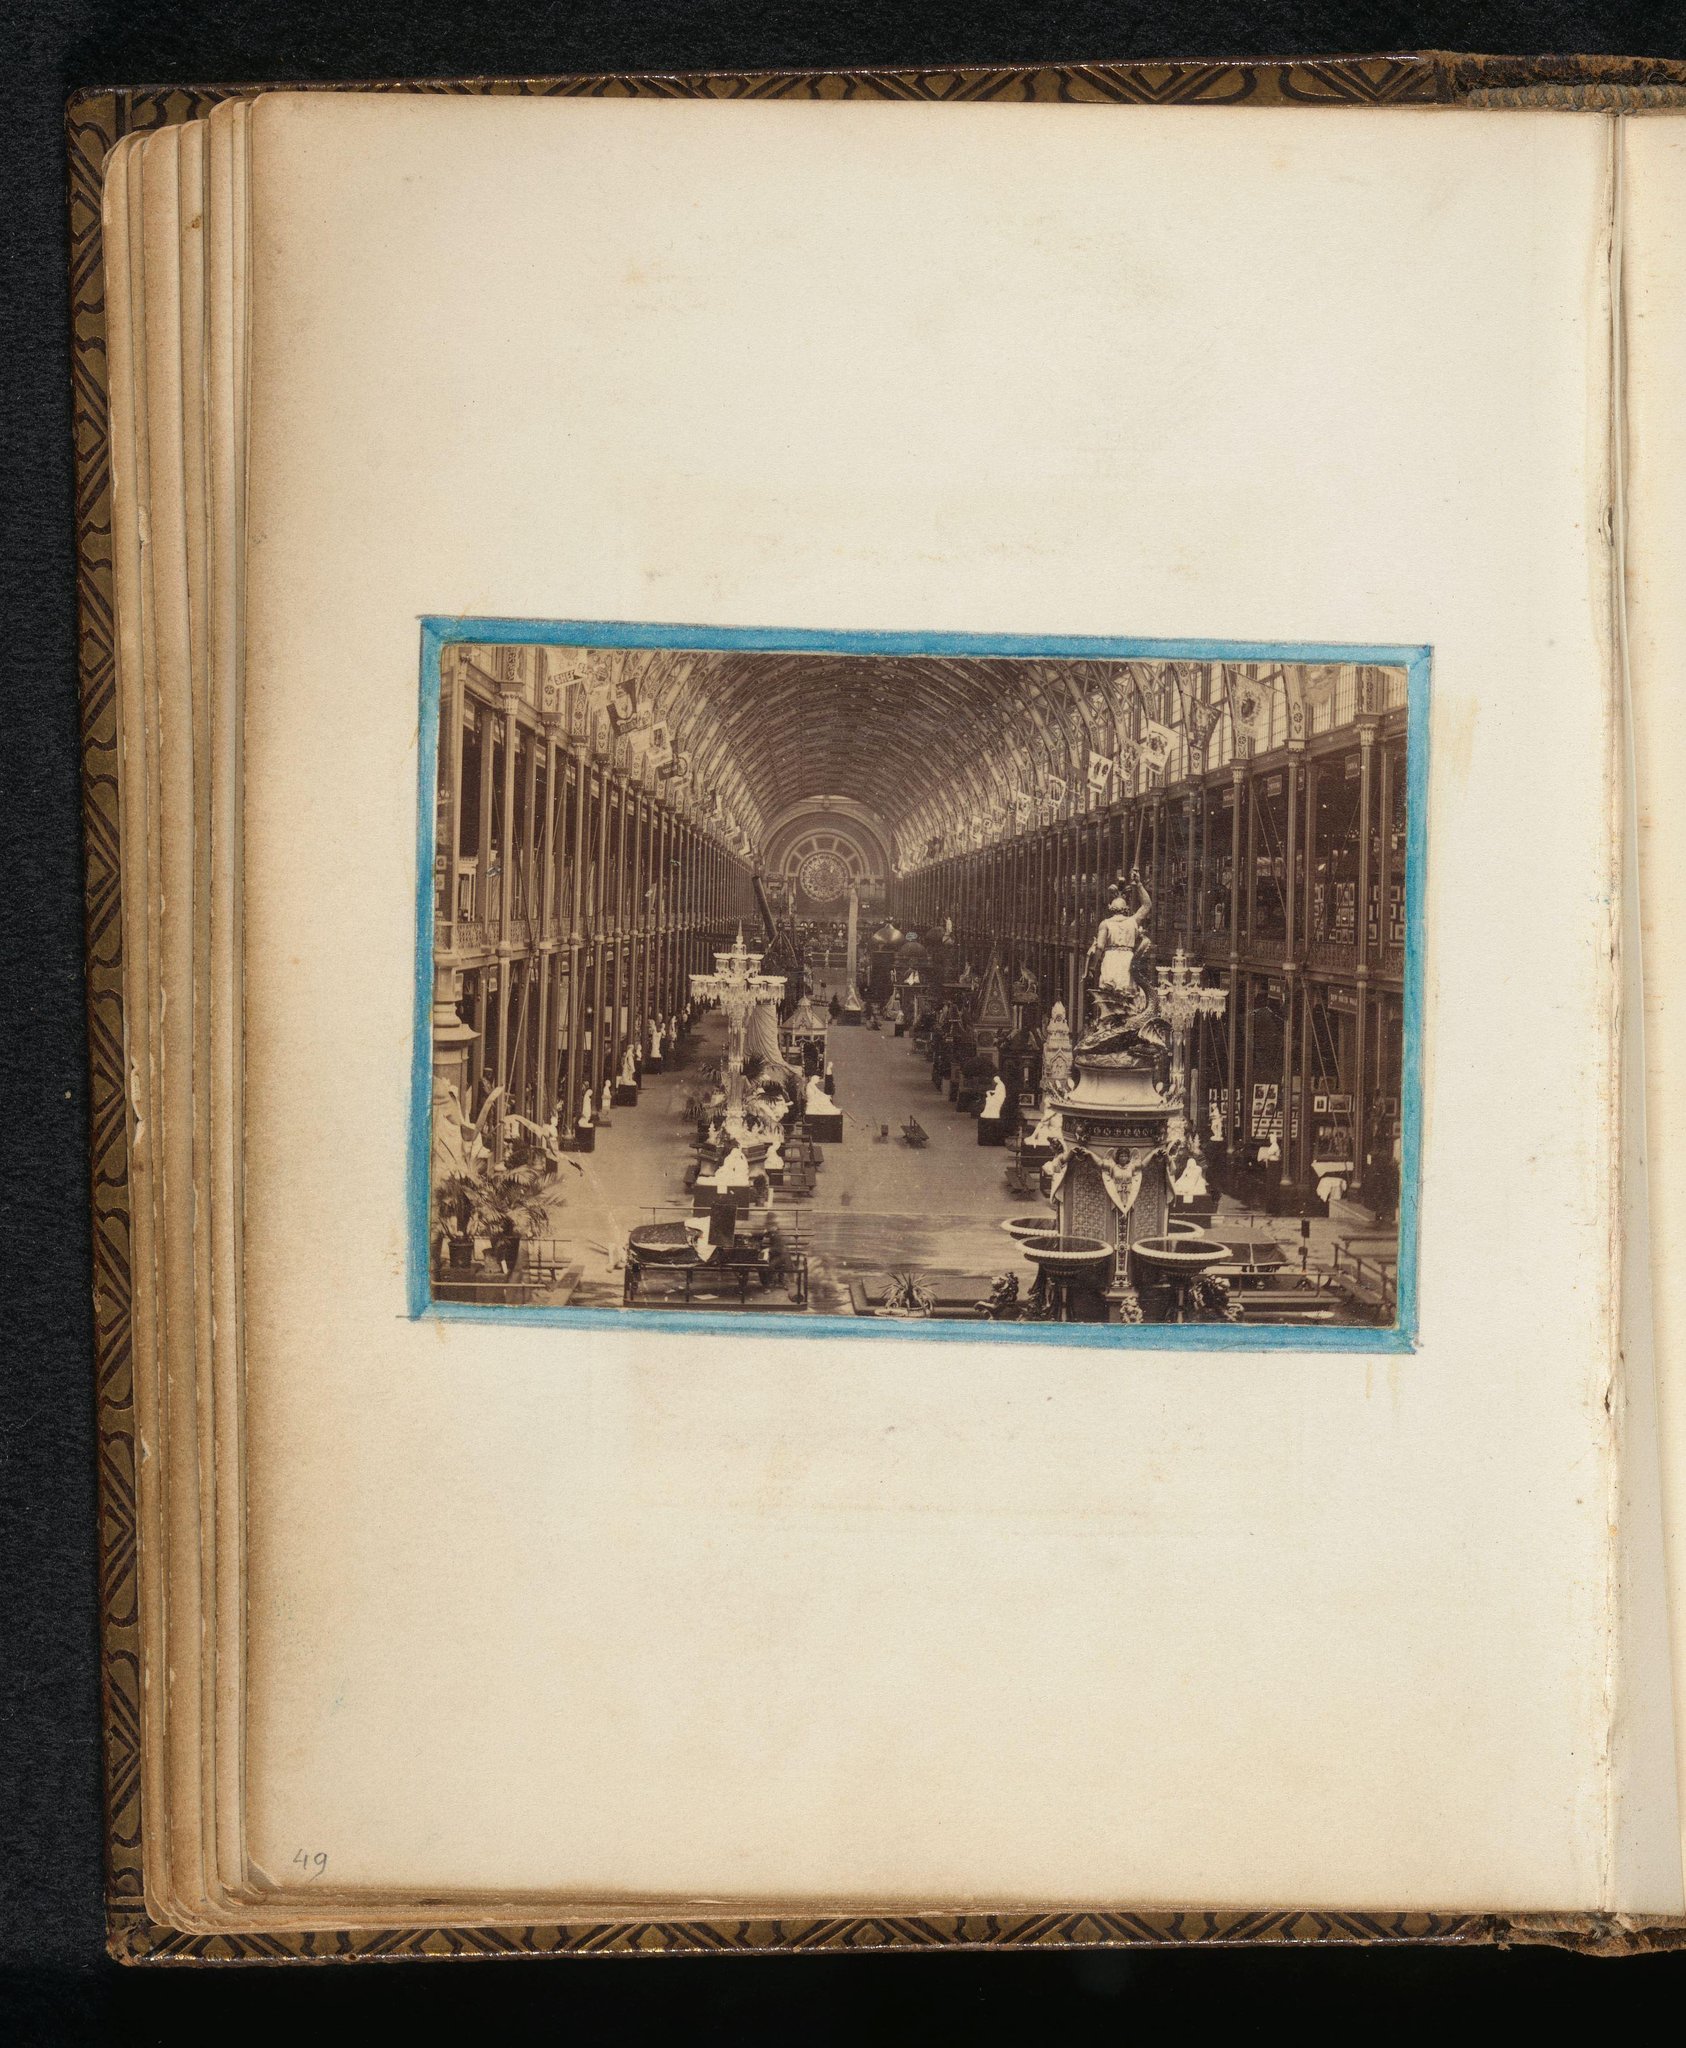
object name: album leaf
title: International Exhibition 1862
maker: Anonymous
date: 1862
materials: cardboard, photographic support, watercolor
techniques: albumen print, aquarelle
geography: england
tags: world fair, world exhibition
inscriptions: annotation: ‘Spencer Wyndham / "We two ... auld lang syne"’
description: Interieur van Crystal Palace tijdens de wereldtentoonstelling van 1862. Foto op albumblad in album met 68 foto's merendeels met geaquarelleerde randversieringen. Het zijn voornamelijk portretten op carte-de-visite formaat.